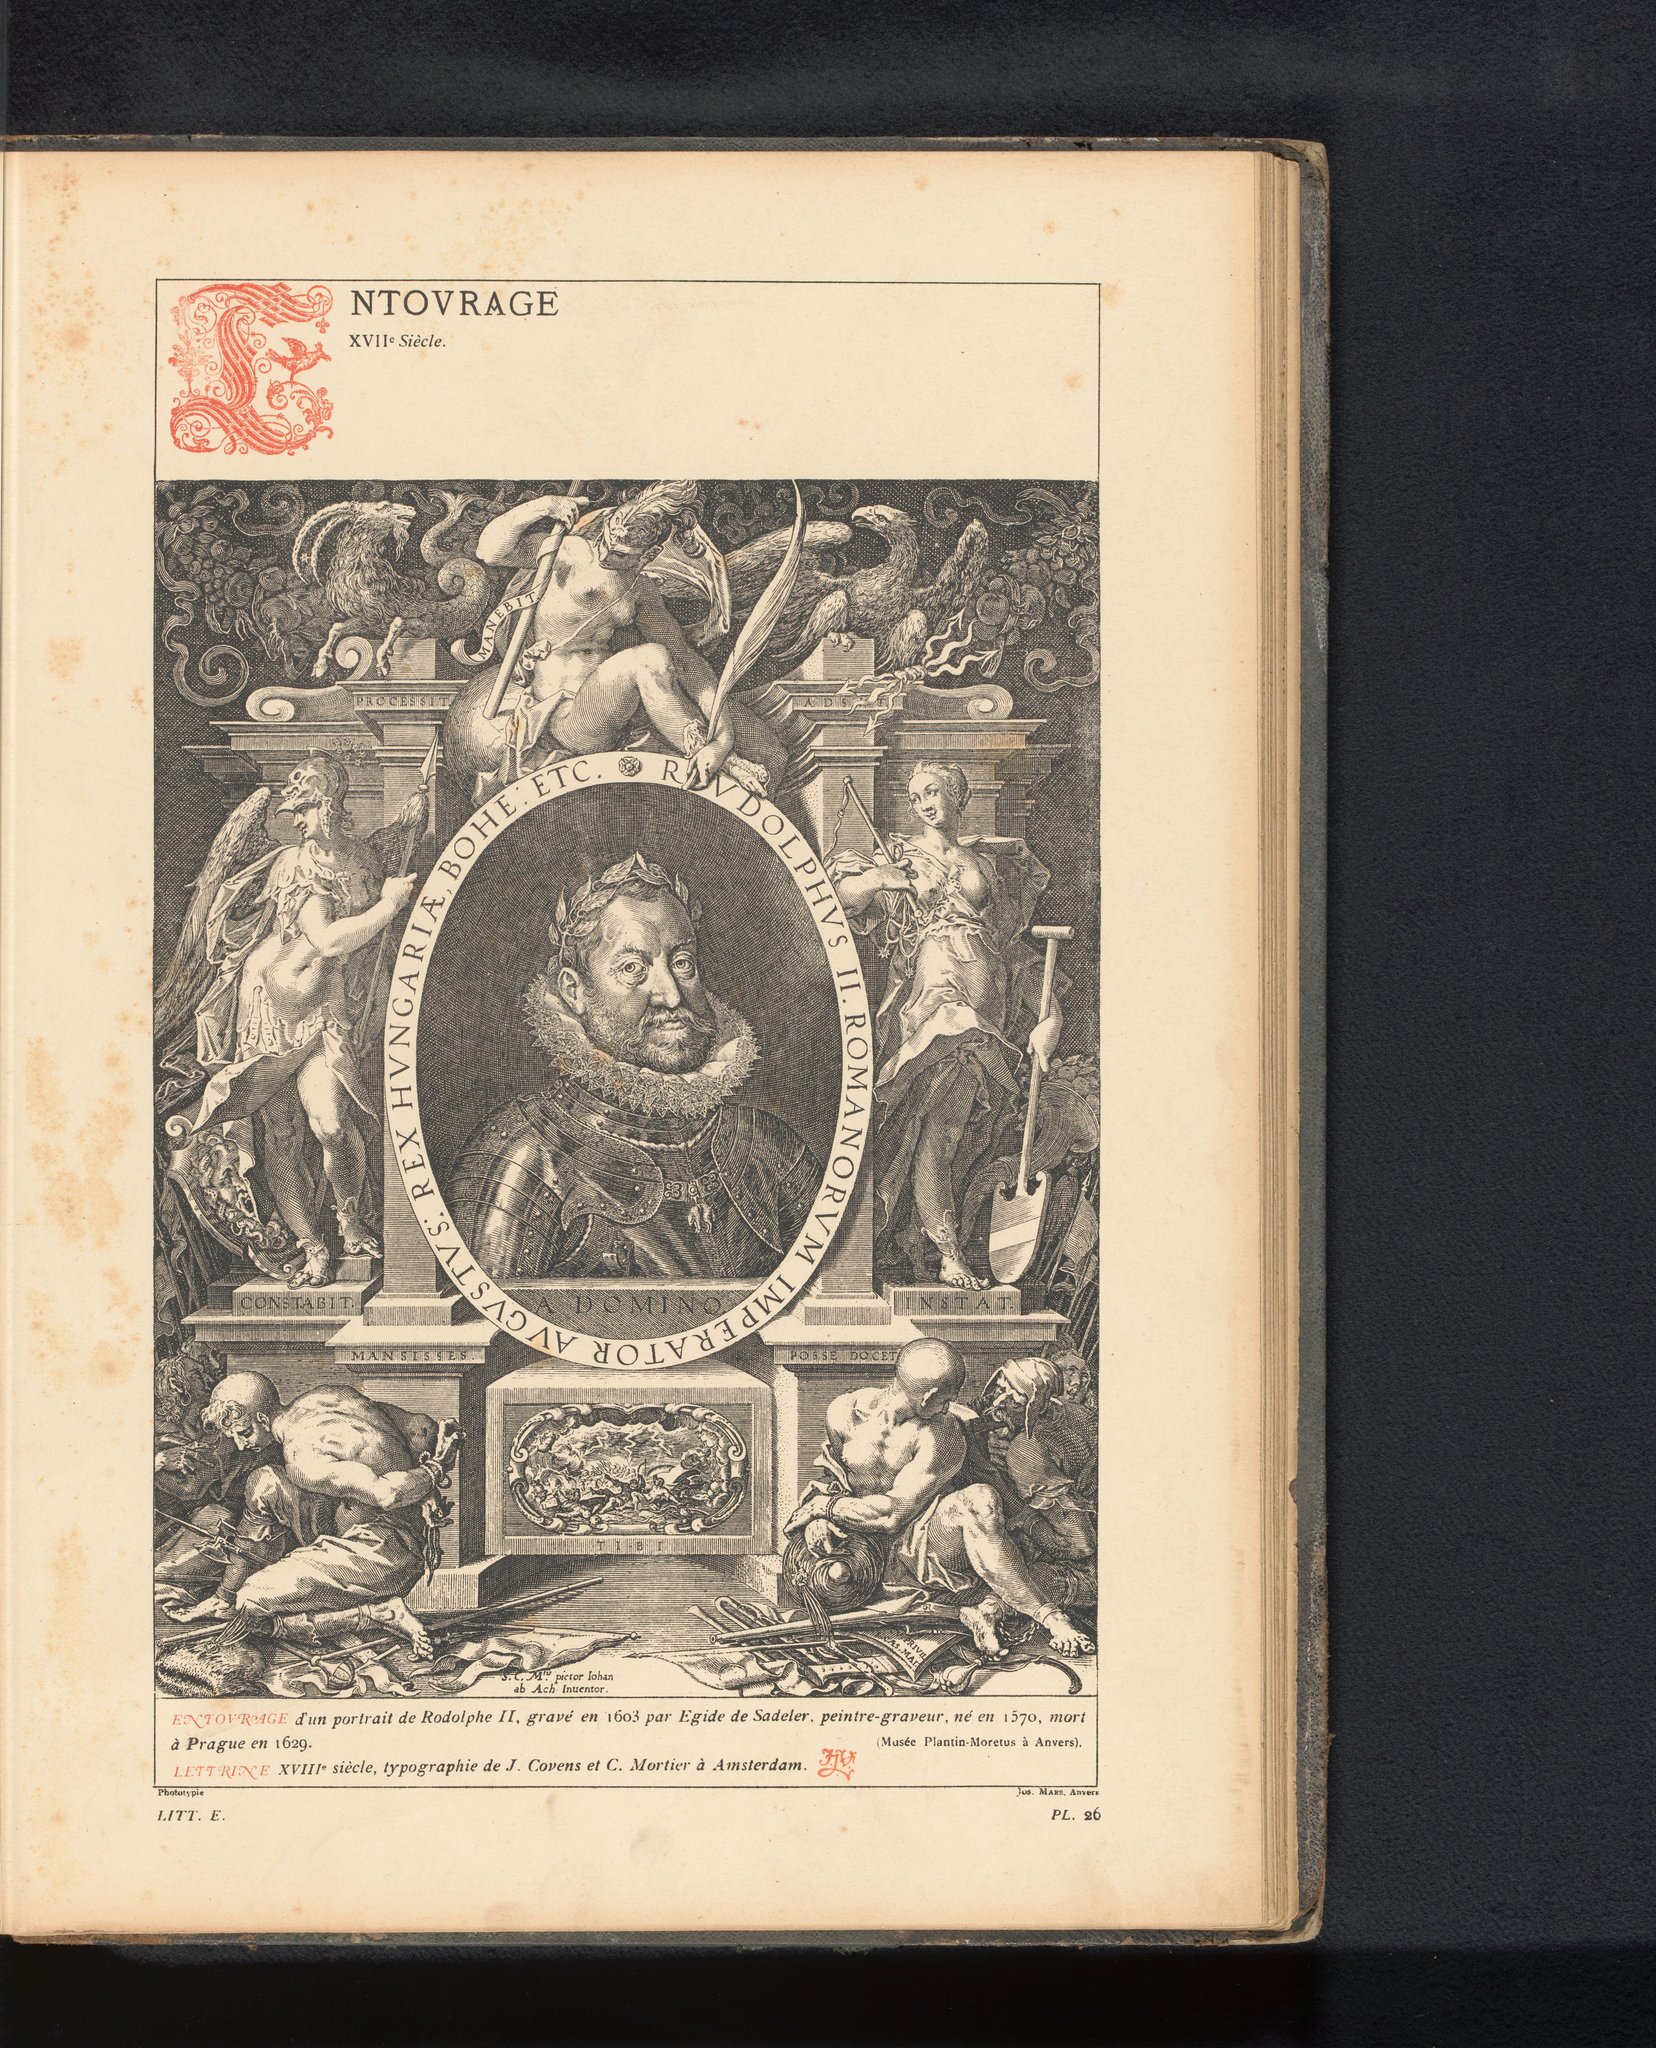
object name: page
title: Entourage, XVIIe Siècle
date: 1875-1880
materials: paper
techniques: photolithography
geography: amsterdam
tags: vienna, prague, rudolf ii van habsburg (duits keizer), historical persons, emperor, roman deities, and foreign deities included in the classical pantheon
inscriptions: inscription: ‘ENTOURAGE d'un portrait (...)’, inscription: ‘LITT. E. - PL. 26’, monogram: ‘JJvY’